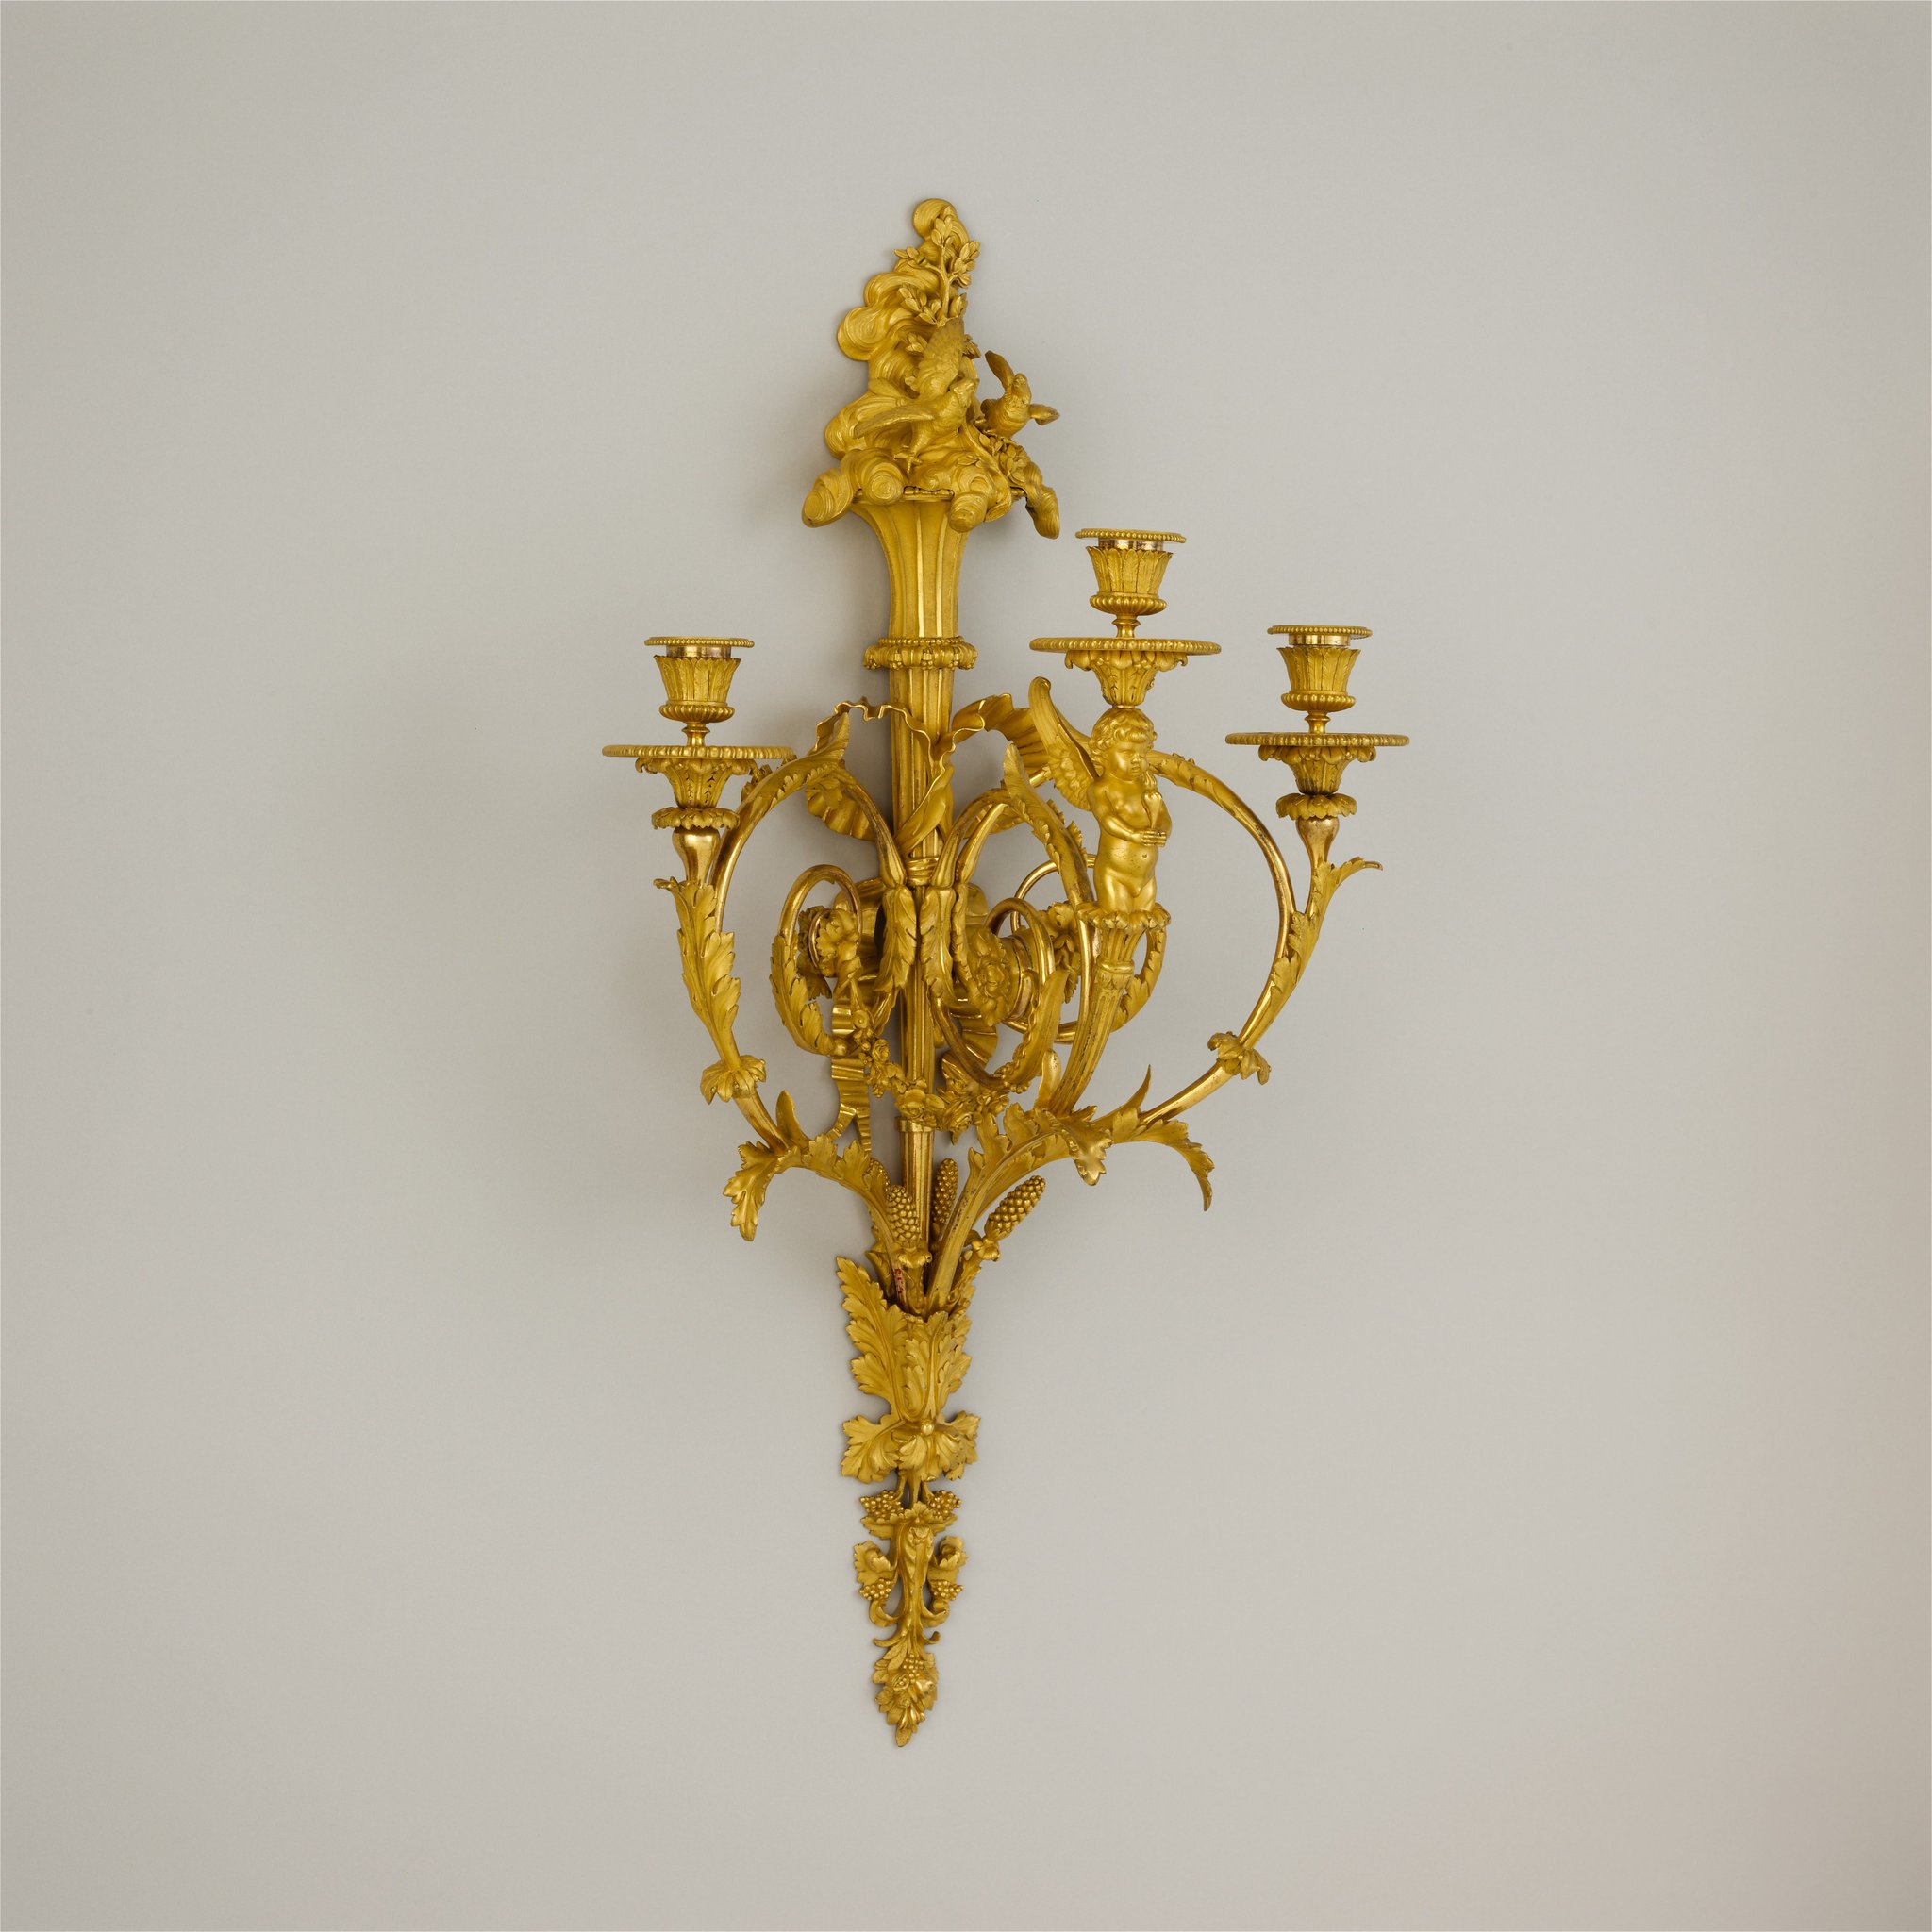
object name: wall bracket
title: Three-light wall brackets (set of four)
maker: f. l. feuchère père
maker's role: modeler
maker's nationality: french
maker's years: 1728-1828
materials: gilt bronze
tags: birds